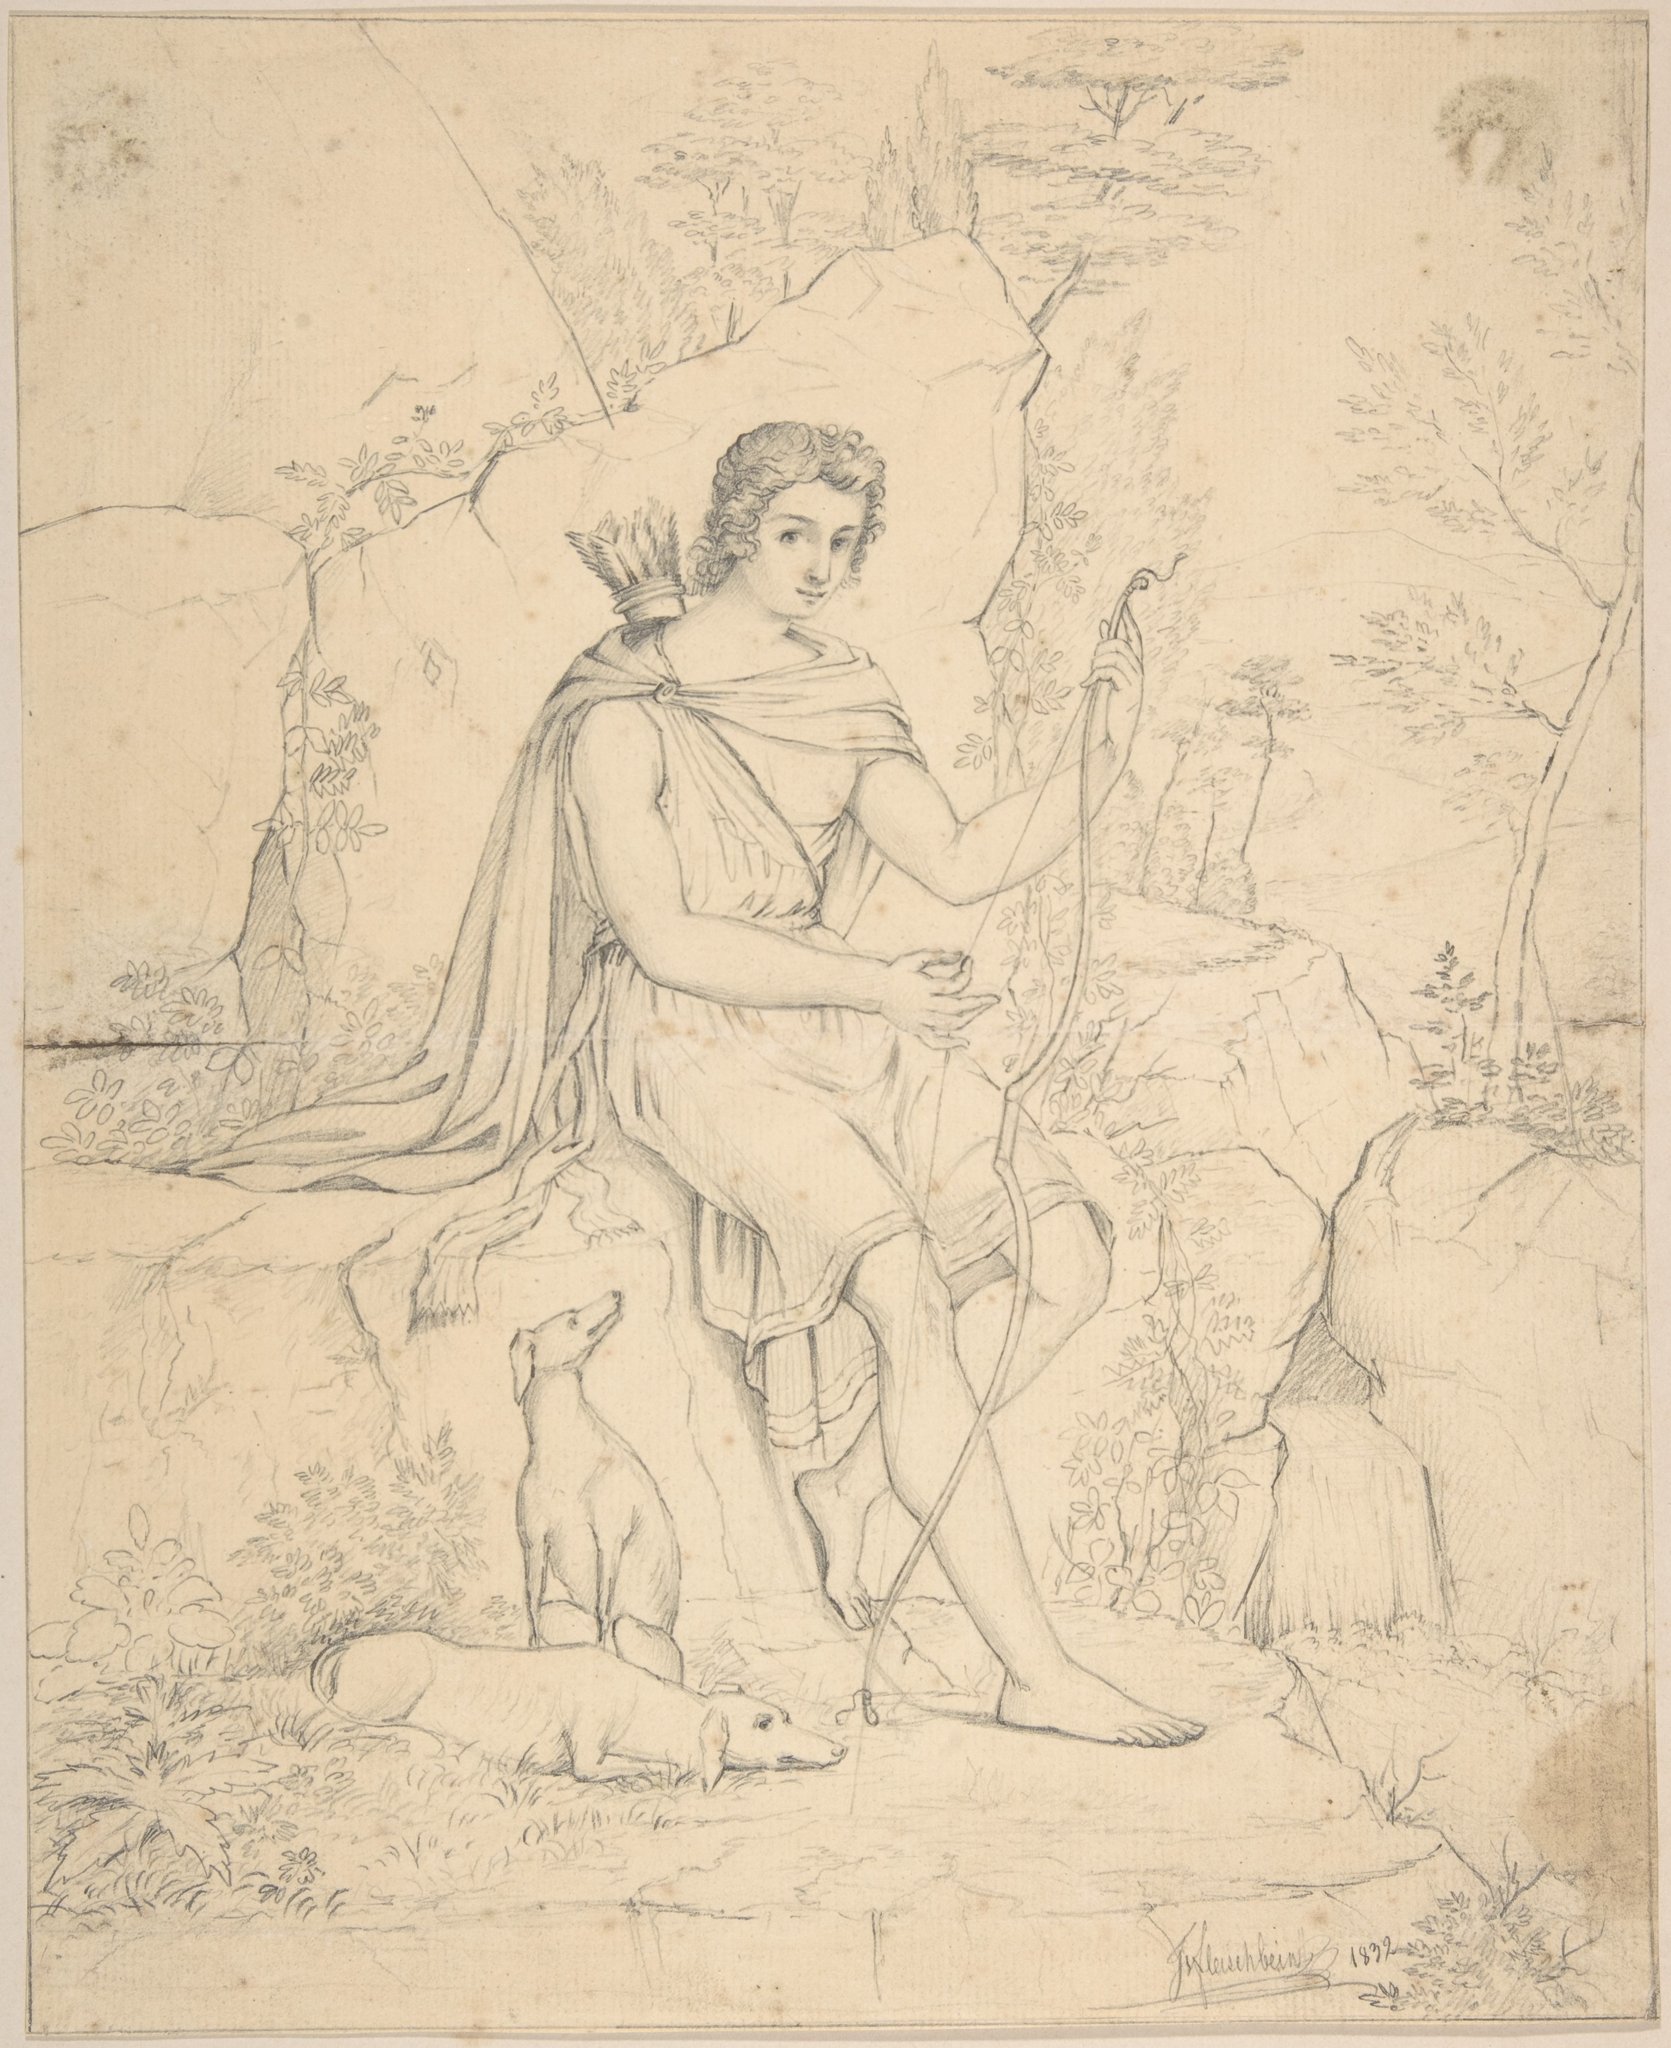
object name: drawing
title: Young Man with Bow and Arrow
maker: françois jacques fleischbein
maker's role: artist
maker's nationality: german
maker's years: 1804-1868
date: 1832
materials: graphite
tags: bow and arrow,men,dogs